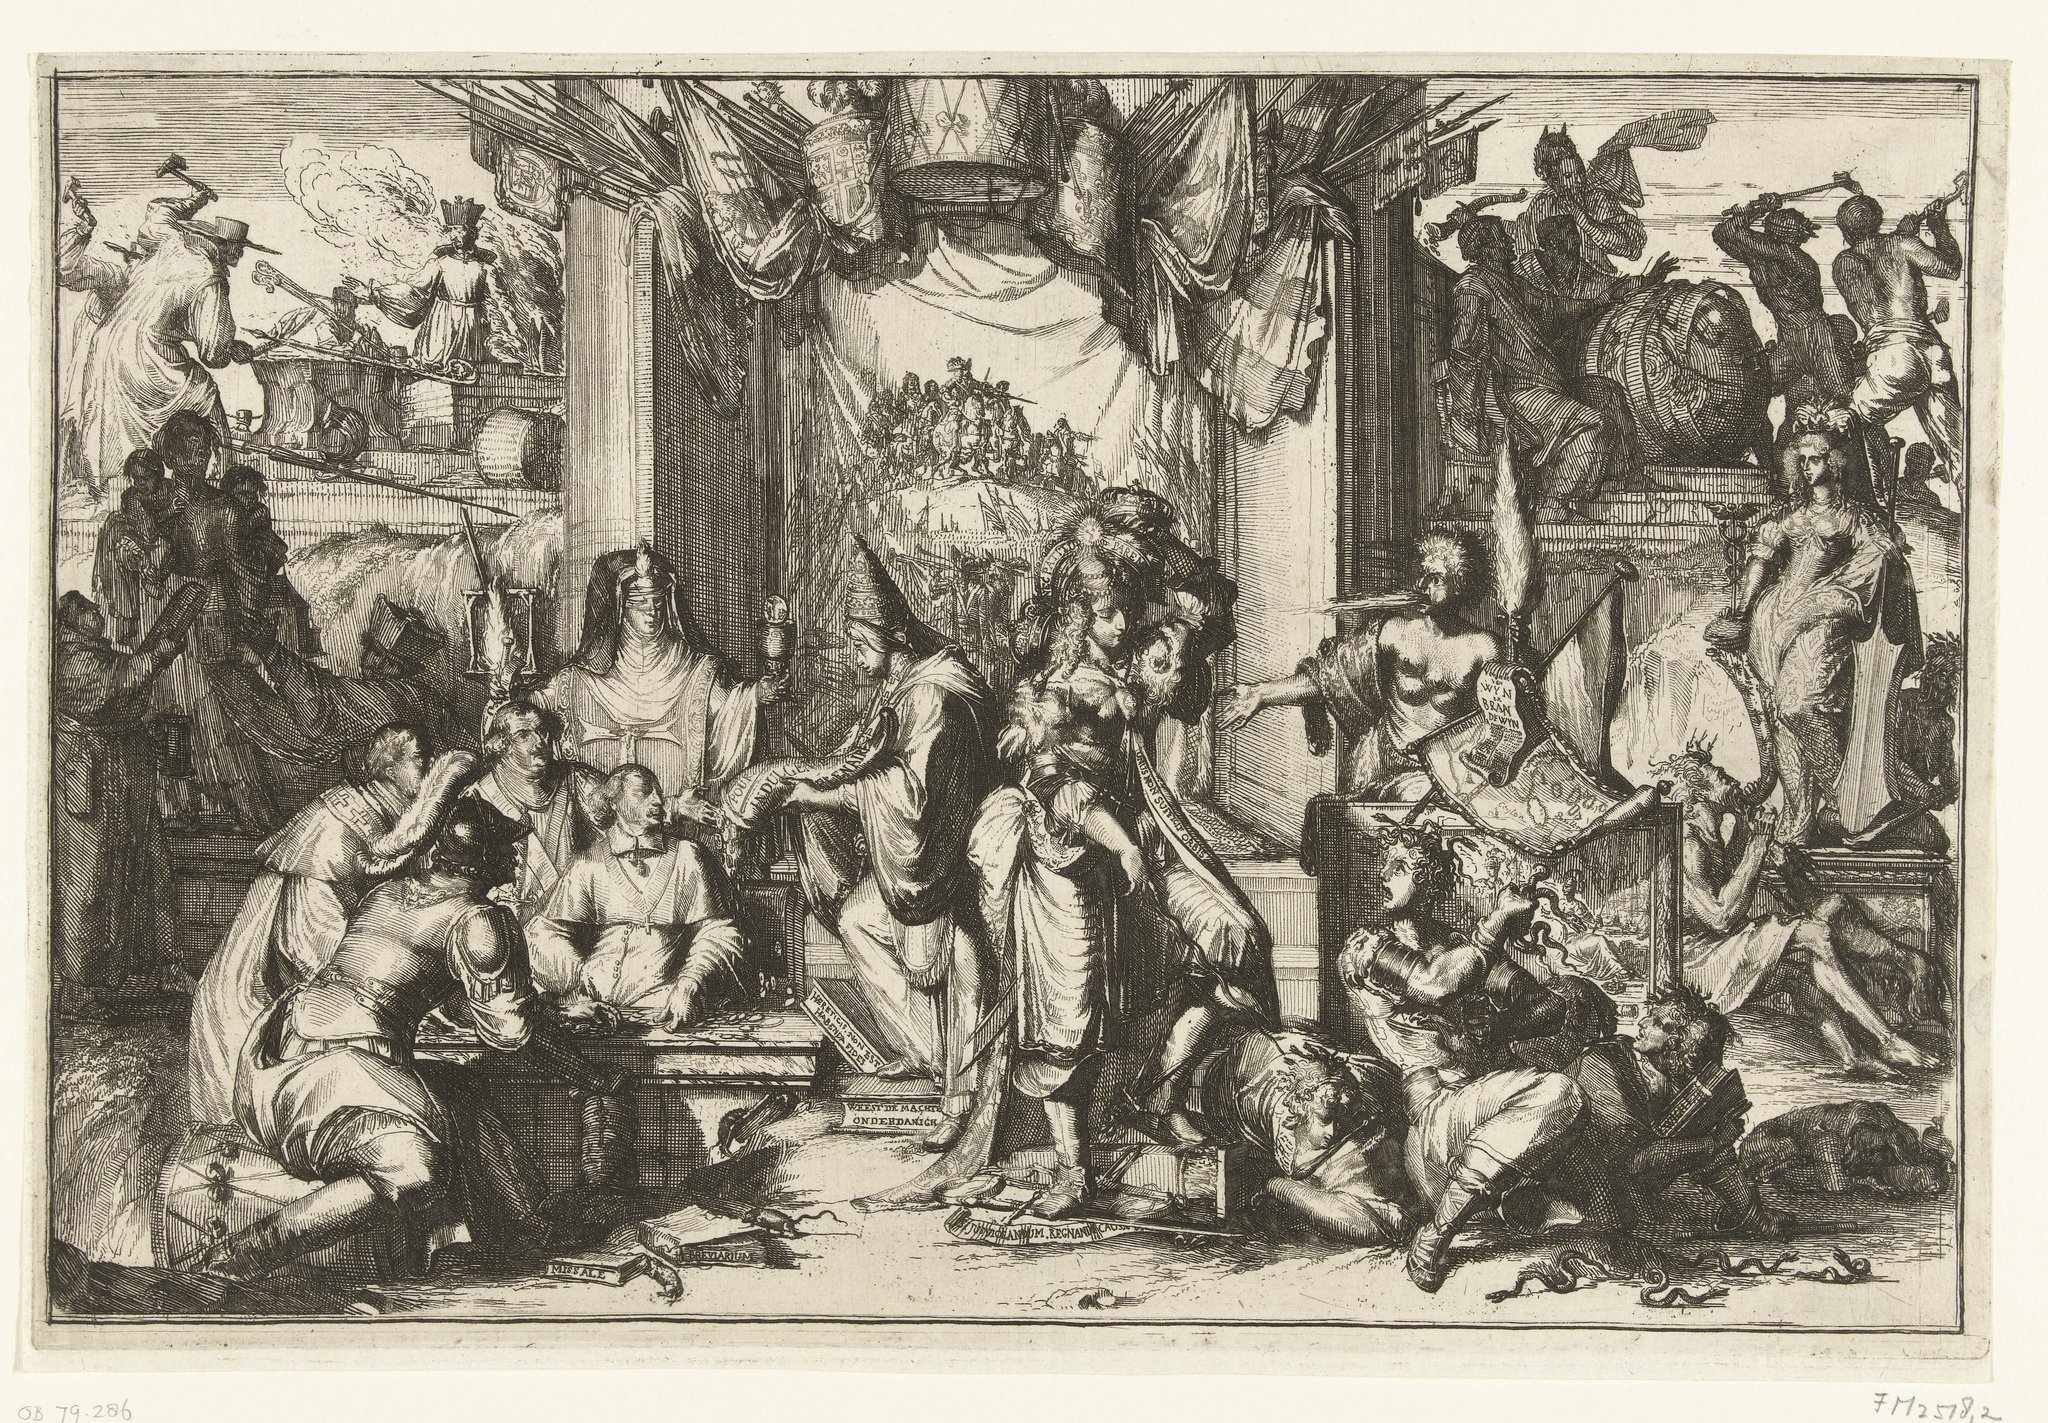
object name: print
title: De kerk en hoogmoed stoken onrust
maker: romeyn de hooghe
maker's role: draughtsman, goldsmith, painter, print maker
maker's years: 1645-1708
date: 1674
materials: paper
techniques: etching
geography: amsterdam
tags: lodewijk xiv (koning van frankrijk), maximiliaan hendrik van beieren, paris, envy; 'invidia' (ripa) ~ personification of one of the seven deadly sins, pride; 'superbia' (ripa) ~ personification of one of the seven deadly sins, netherlands, rampjaar (disaster year)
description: De kerk en hoogmoed stoken intriges en onrust. De Roomse kerk zet de bisschoppen van Münster, Keulen en Straatsburg en Wilhelm Egon von Fürstenberg aan tot oorlog. Centraal de verbeelding van de hoogmoed van de Franse koning Lodewijk XIV die meer kronen op het hoofd heeft dan hij kan dragen. Rechts wordt de welvaart van de Republiek met afgunst bekeken. Op de achtergrond smeden katholieken bisschopsstaven om tot wapens, rechts worden de banden om de wereld losgeslagen. Allegorie op de politieke situatie in de Republiek in het jaar 1674. Genummerd rechtsboven: 2.